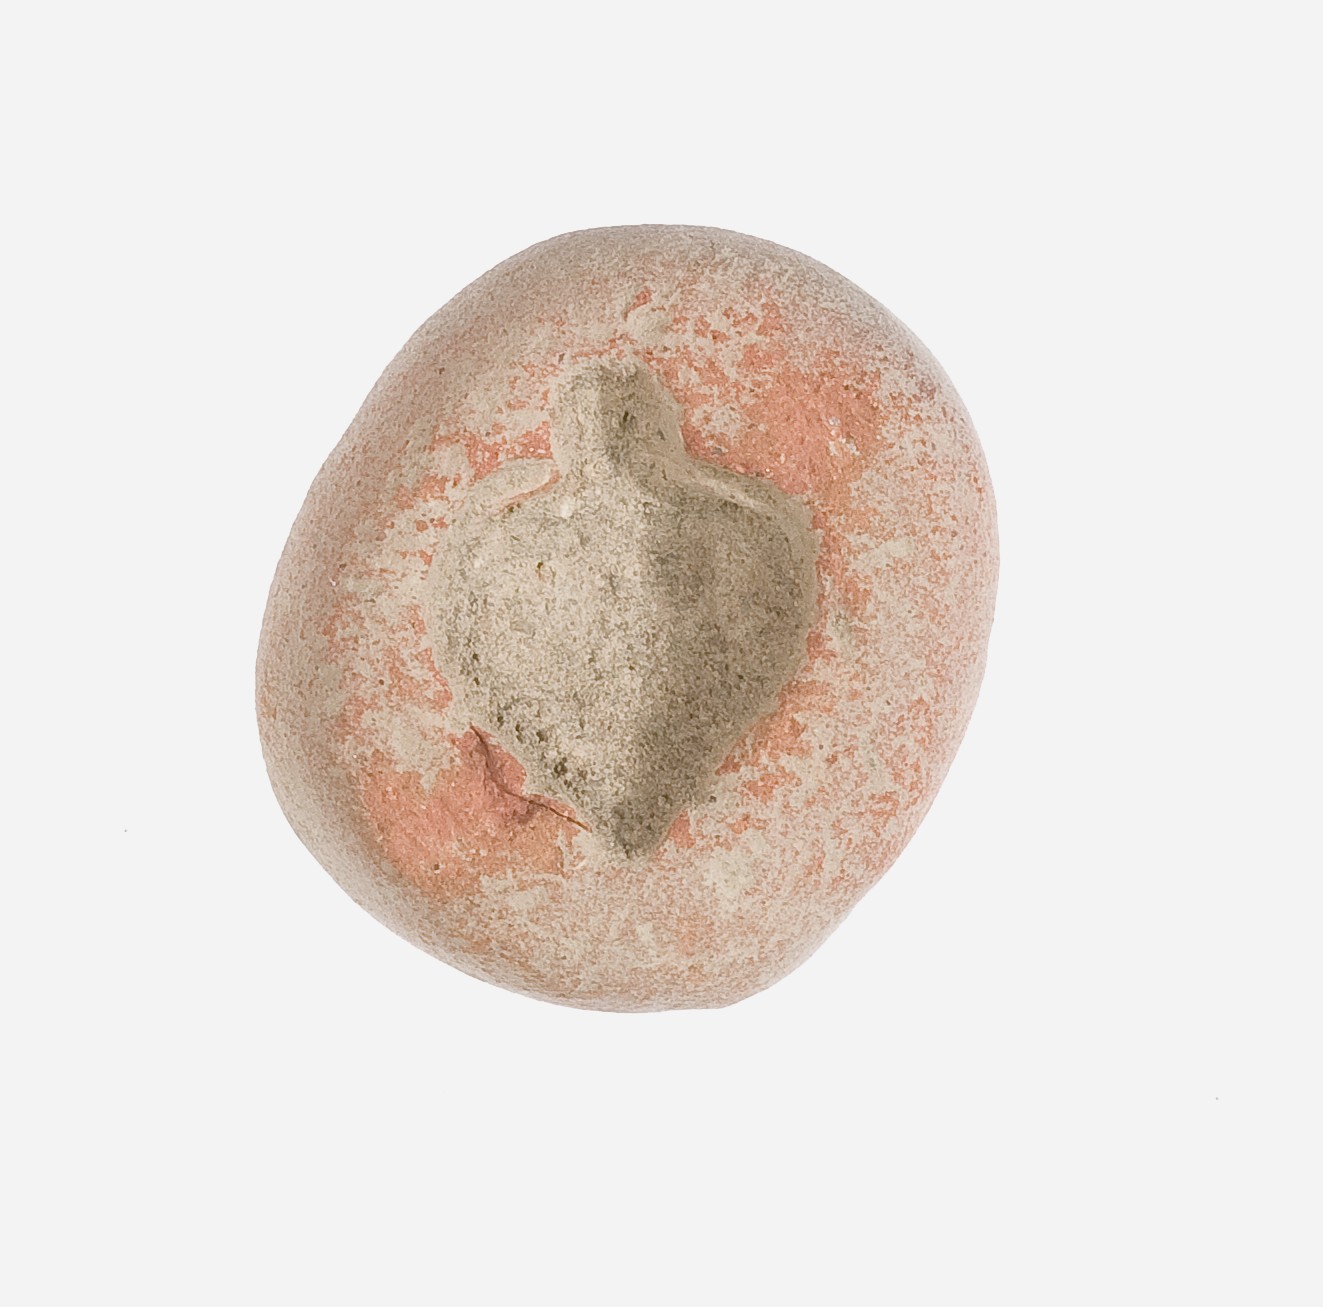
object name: mold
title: Fruit Mold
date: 1390-1352 BCE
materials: pottery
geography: egypt